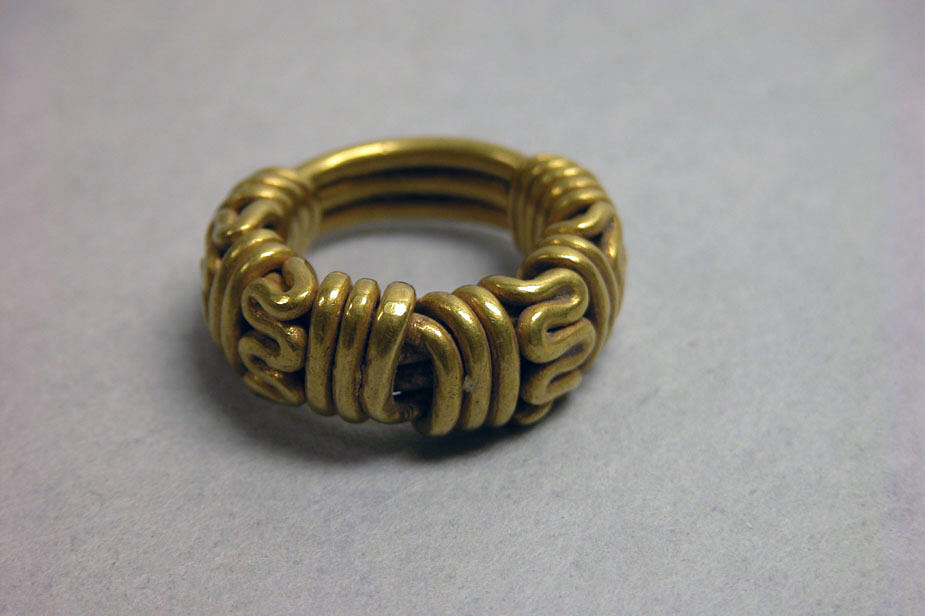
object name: ring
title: Ring with Twisted Coil Motif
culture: indonesian, javanese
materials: gold